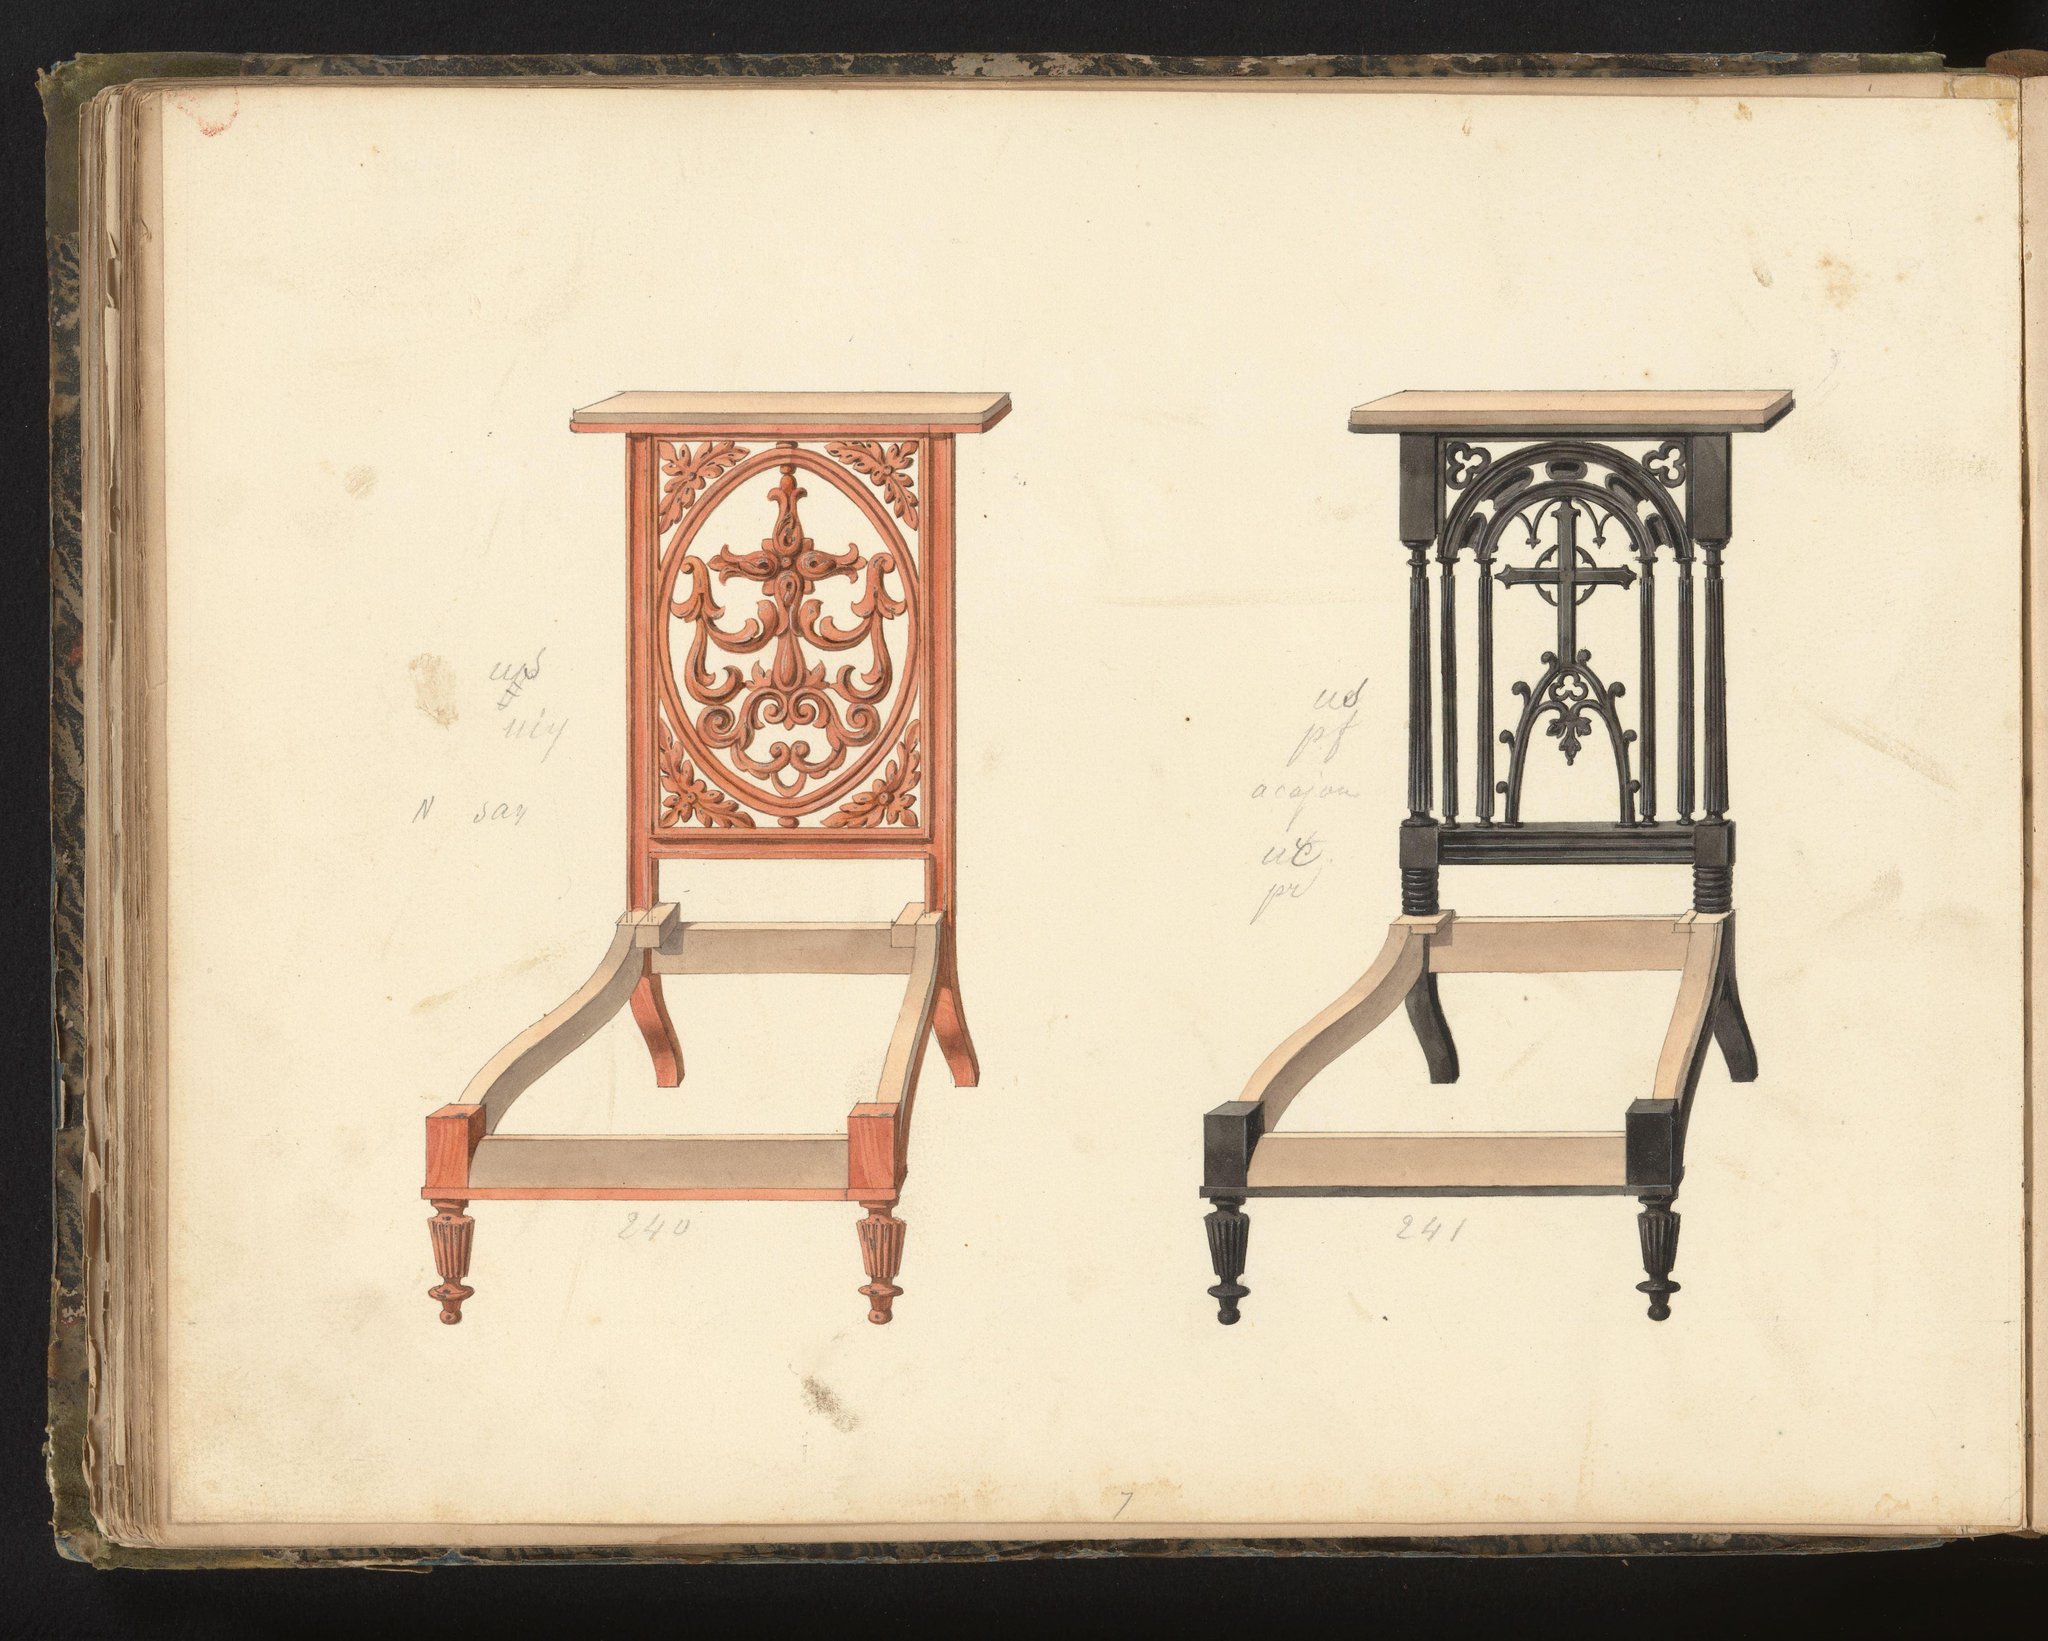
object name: album leaf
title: Twee ontwerpen voor prie-dieu's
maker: Anonymous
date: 1825-1839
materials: ink, paper, pencil, watercolor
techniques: brush, pen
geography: paris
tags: kneeling-chair, furniture for special use (+ wood and other phytogenic material)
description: Twee ontwerpen voor prie-dieu’s (bidstoelen) in twee verschillende houtsoorten. Beide rijk versierd met houtsnijwerk. Het blad op de achterzijde genummerd: 59, het tegenoverliggende blad met informatie (ontbreekt hier) over de afgebeelde meubelen genummerd: 59 bis. Onderdeel van een album met 80 bladen met tekeningen en een prent van gefineerde en gelakte meubelen, alsmede zitmeubelen.